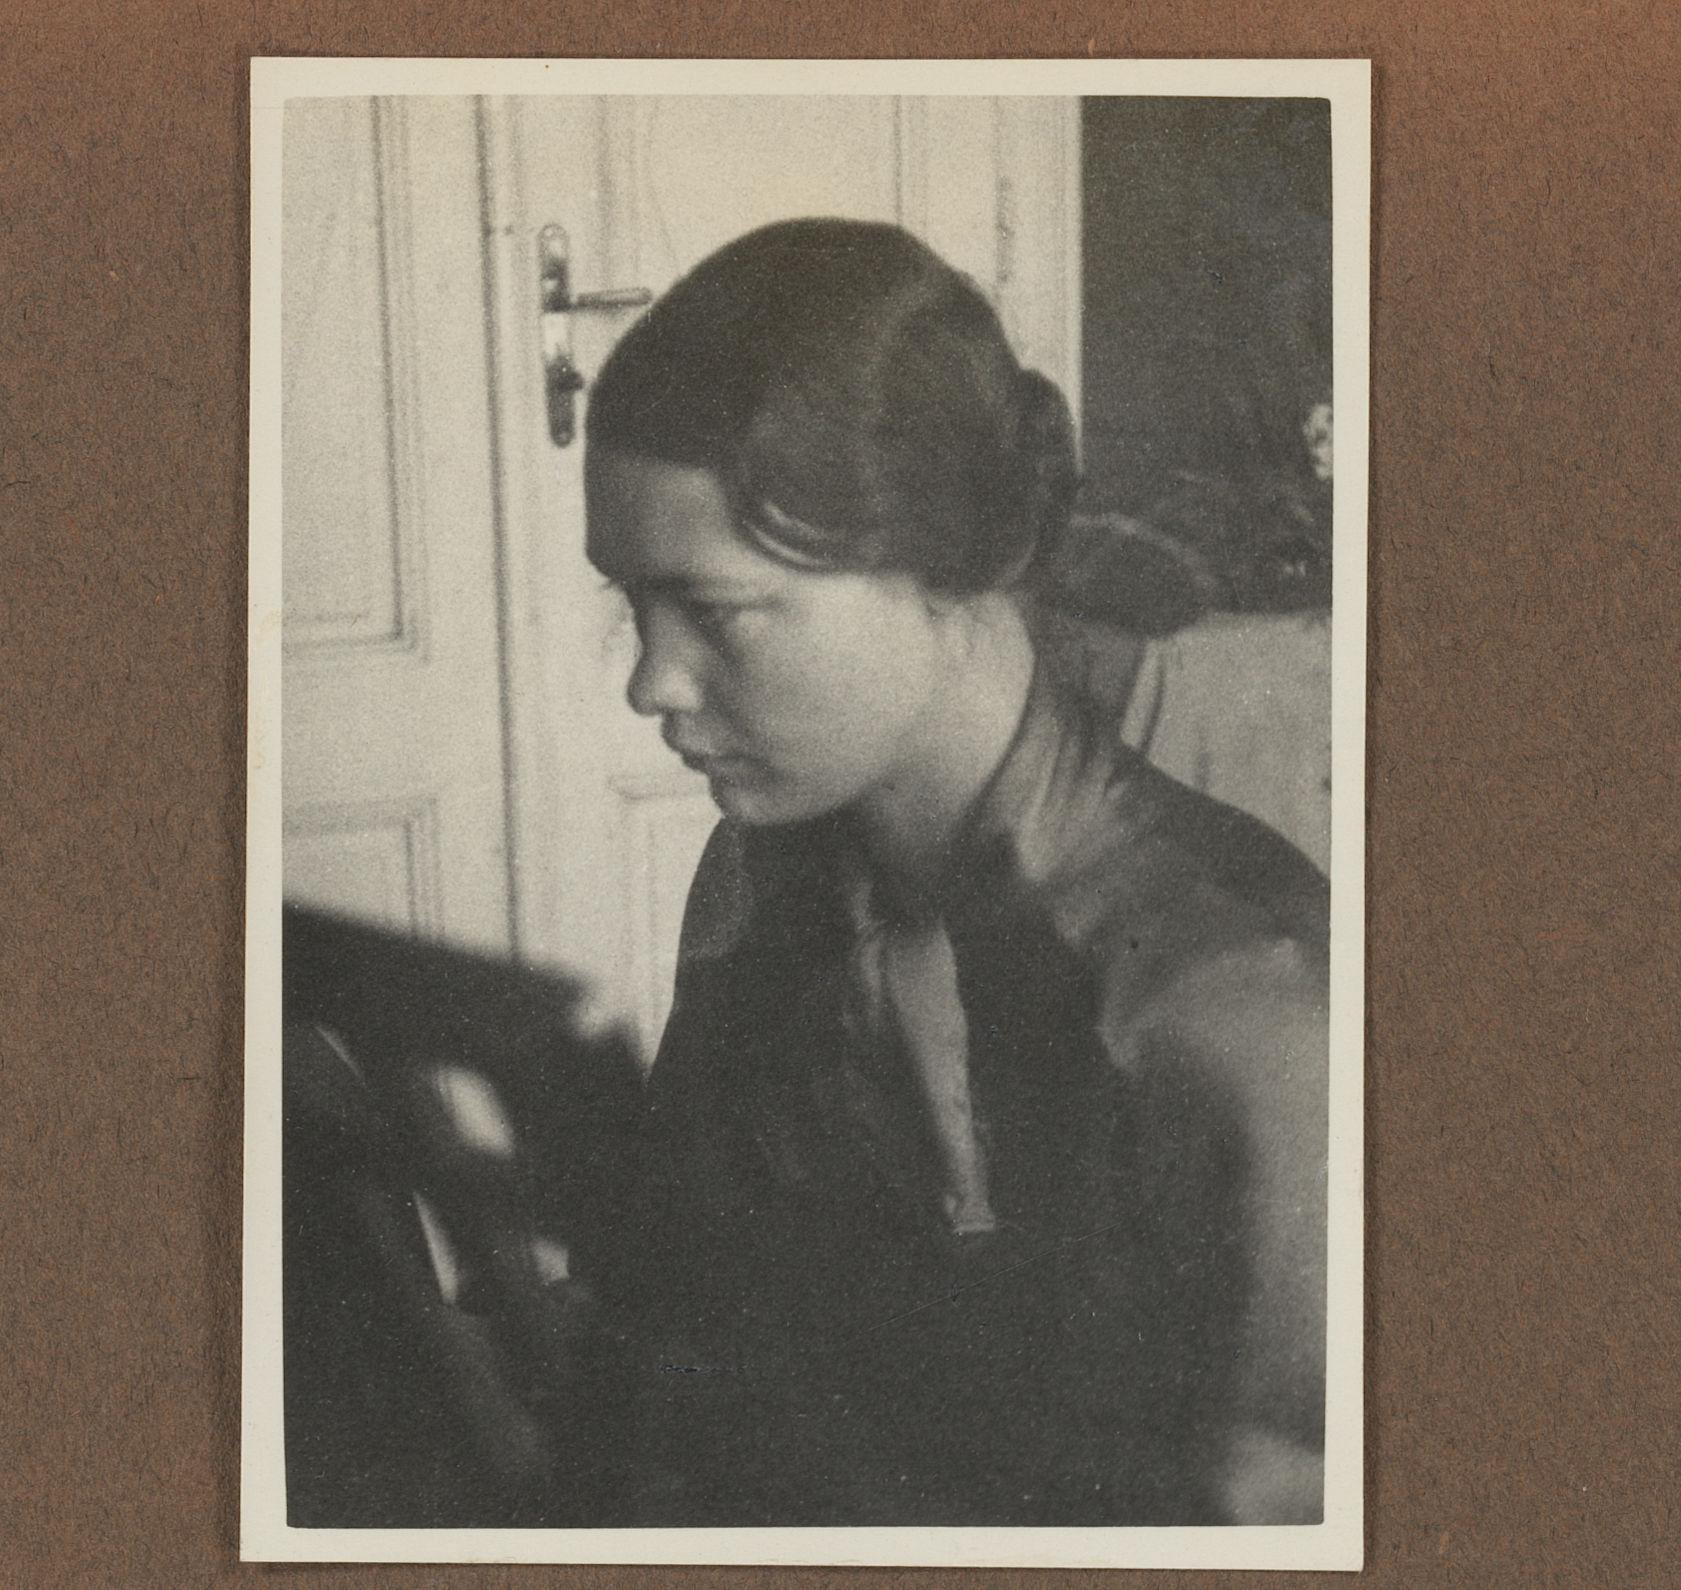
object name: photograph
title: Jonge vrouw aan de piano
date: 1900-1920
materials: photographic support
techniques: photography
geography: netherlands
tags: netherlands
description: Foto op bruin albumblad 54 van familiealbum van Alphons Diepenbrock.